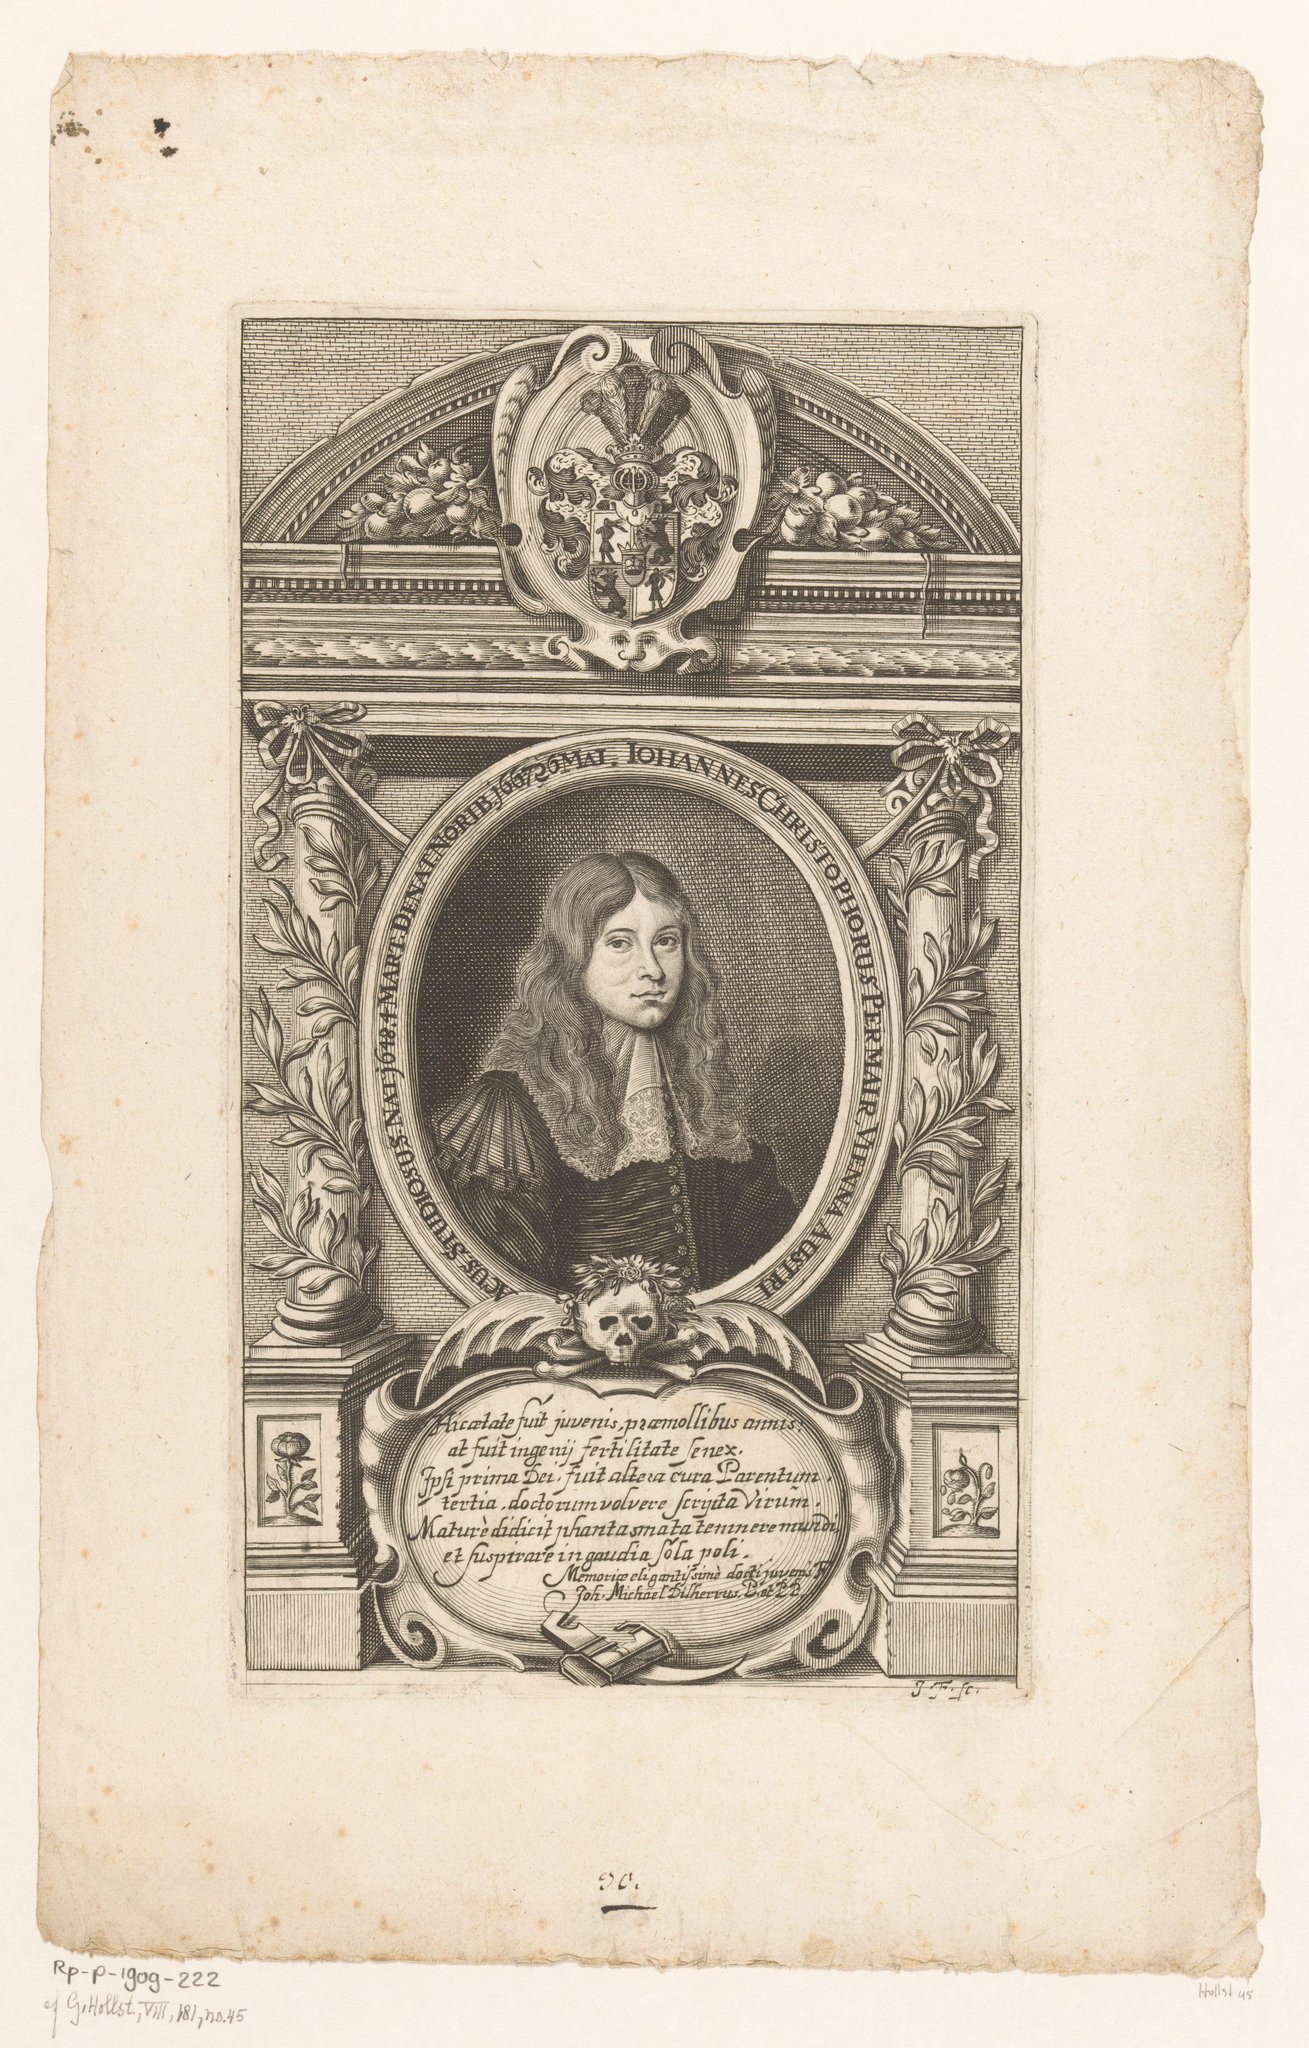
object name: print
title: Portret van Johannes Christoph Permair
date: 1667-1699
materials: paper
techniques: engraving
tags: vienna, historical persons, symbols of death, ornament ~ cartouche, ornament derived from architectural details, armorial bearing, heraldry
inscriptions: collector's mark: Lugt 2228